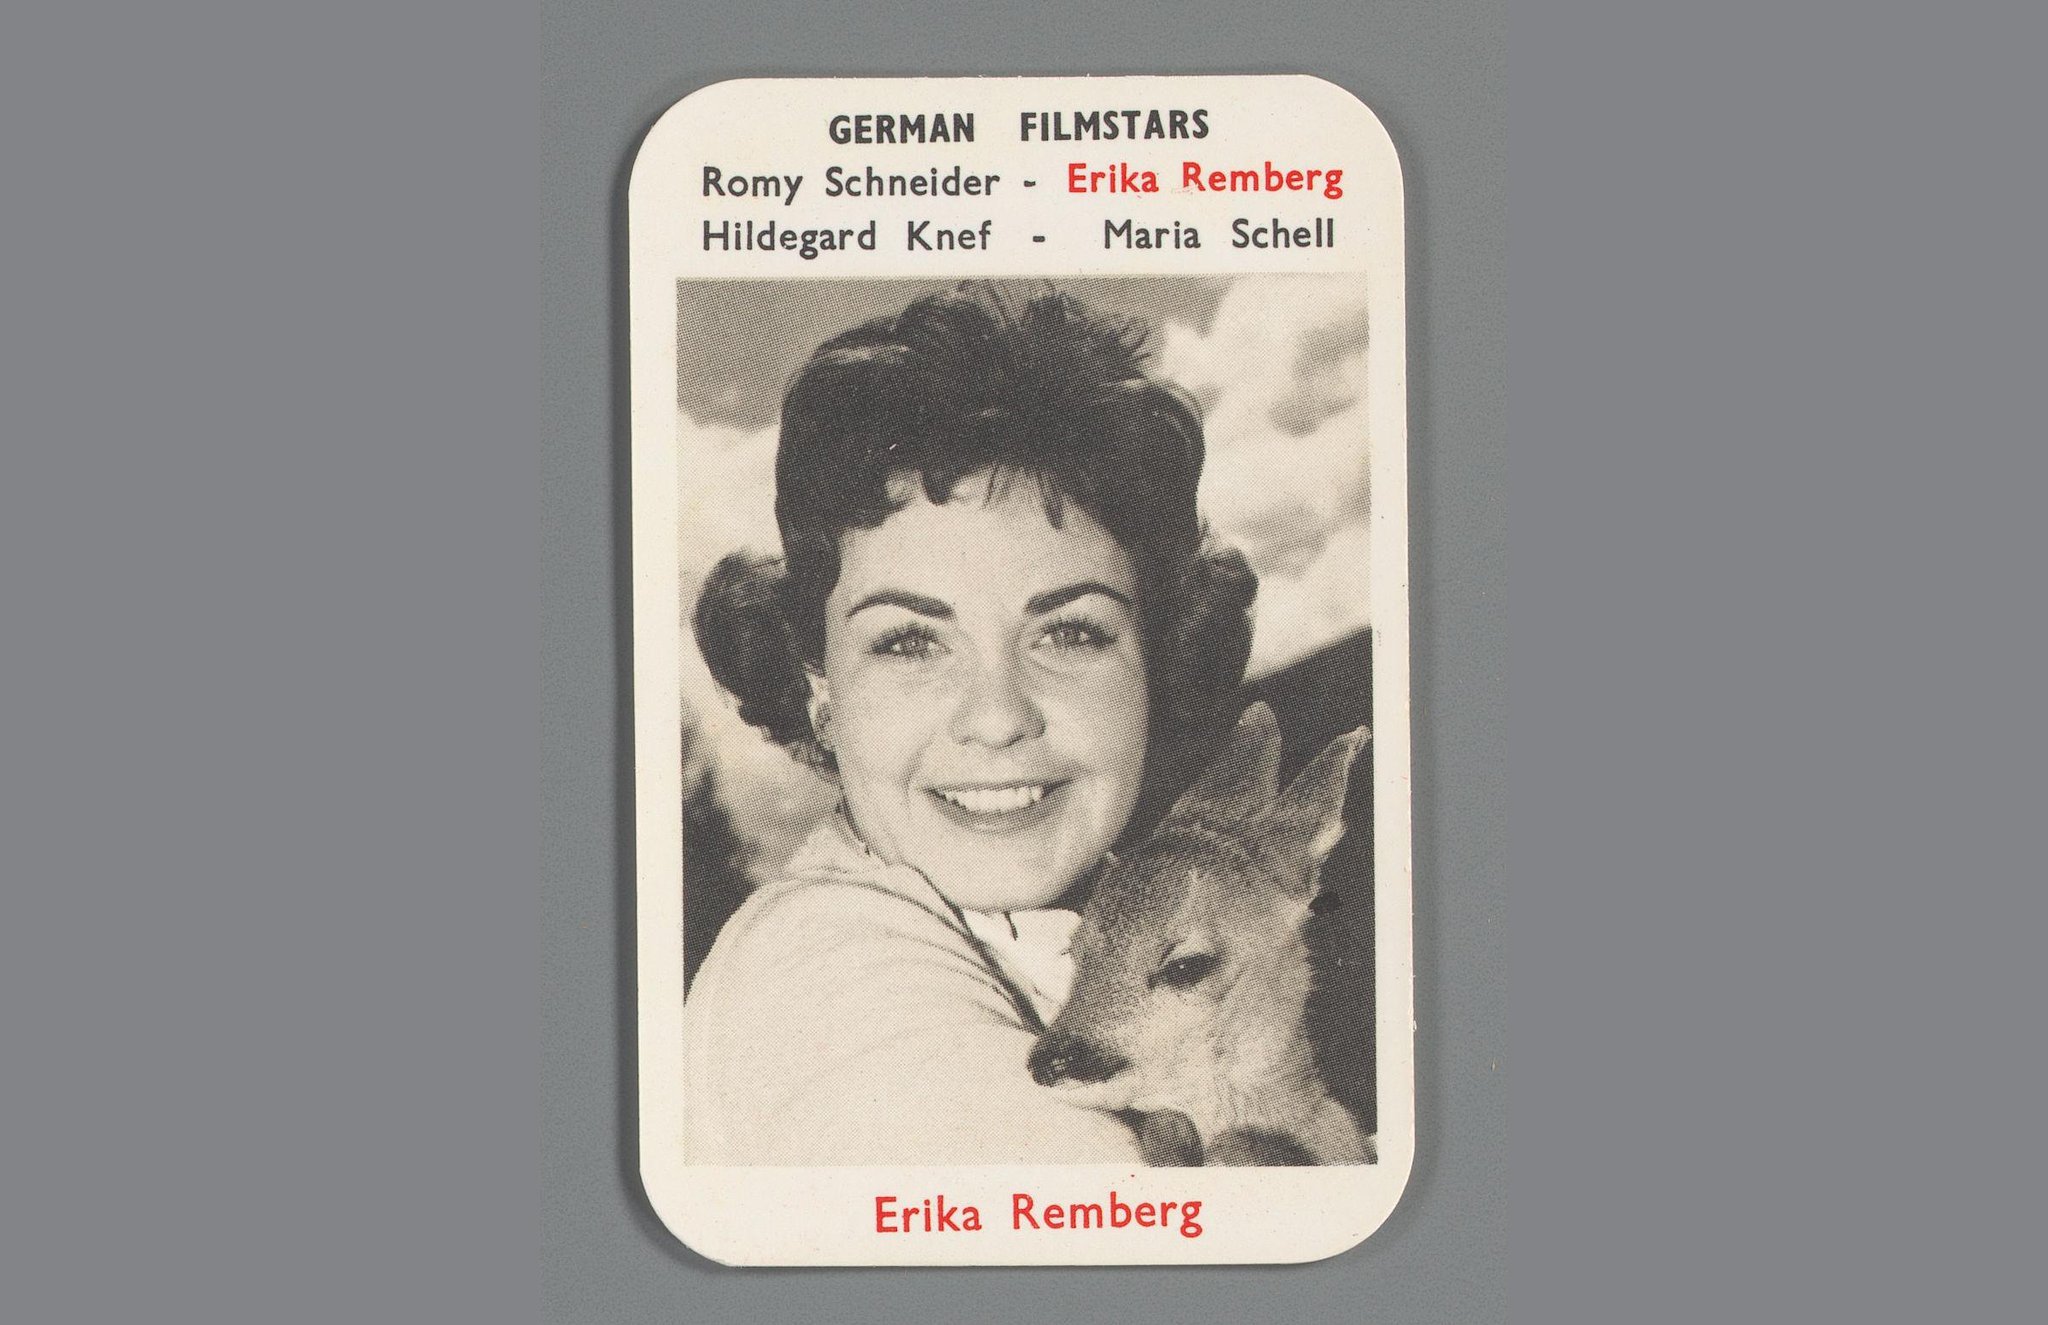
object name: playing card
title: German Filmstars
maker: Anonymous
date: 1960-1970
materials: paper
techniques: autotype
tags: portrait of actor, actress